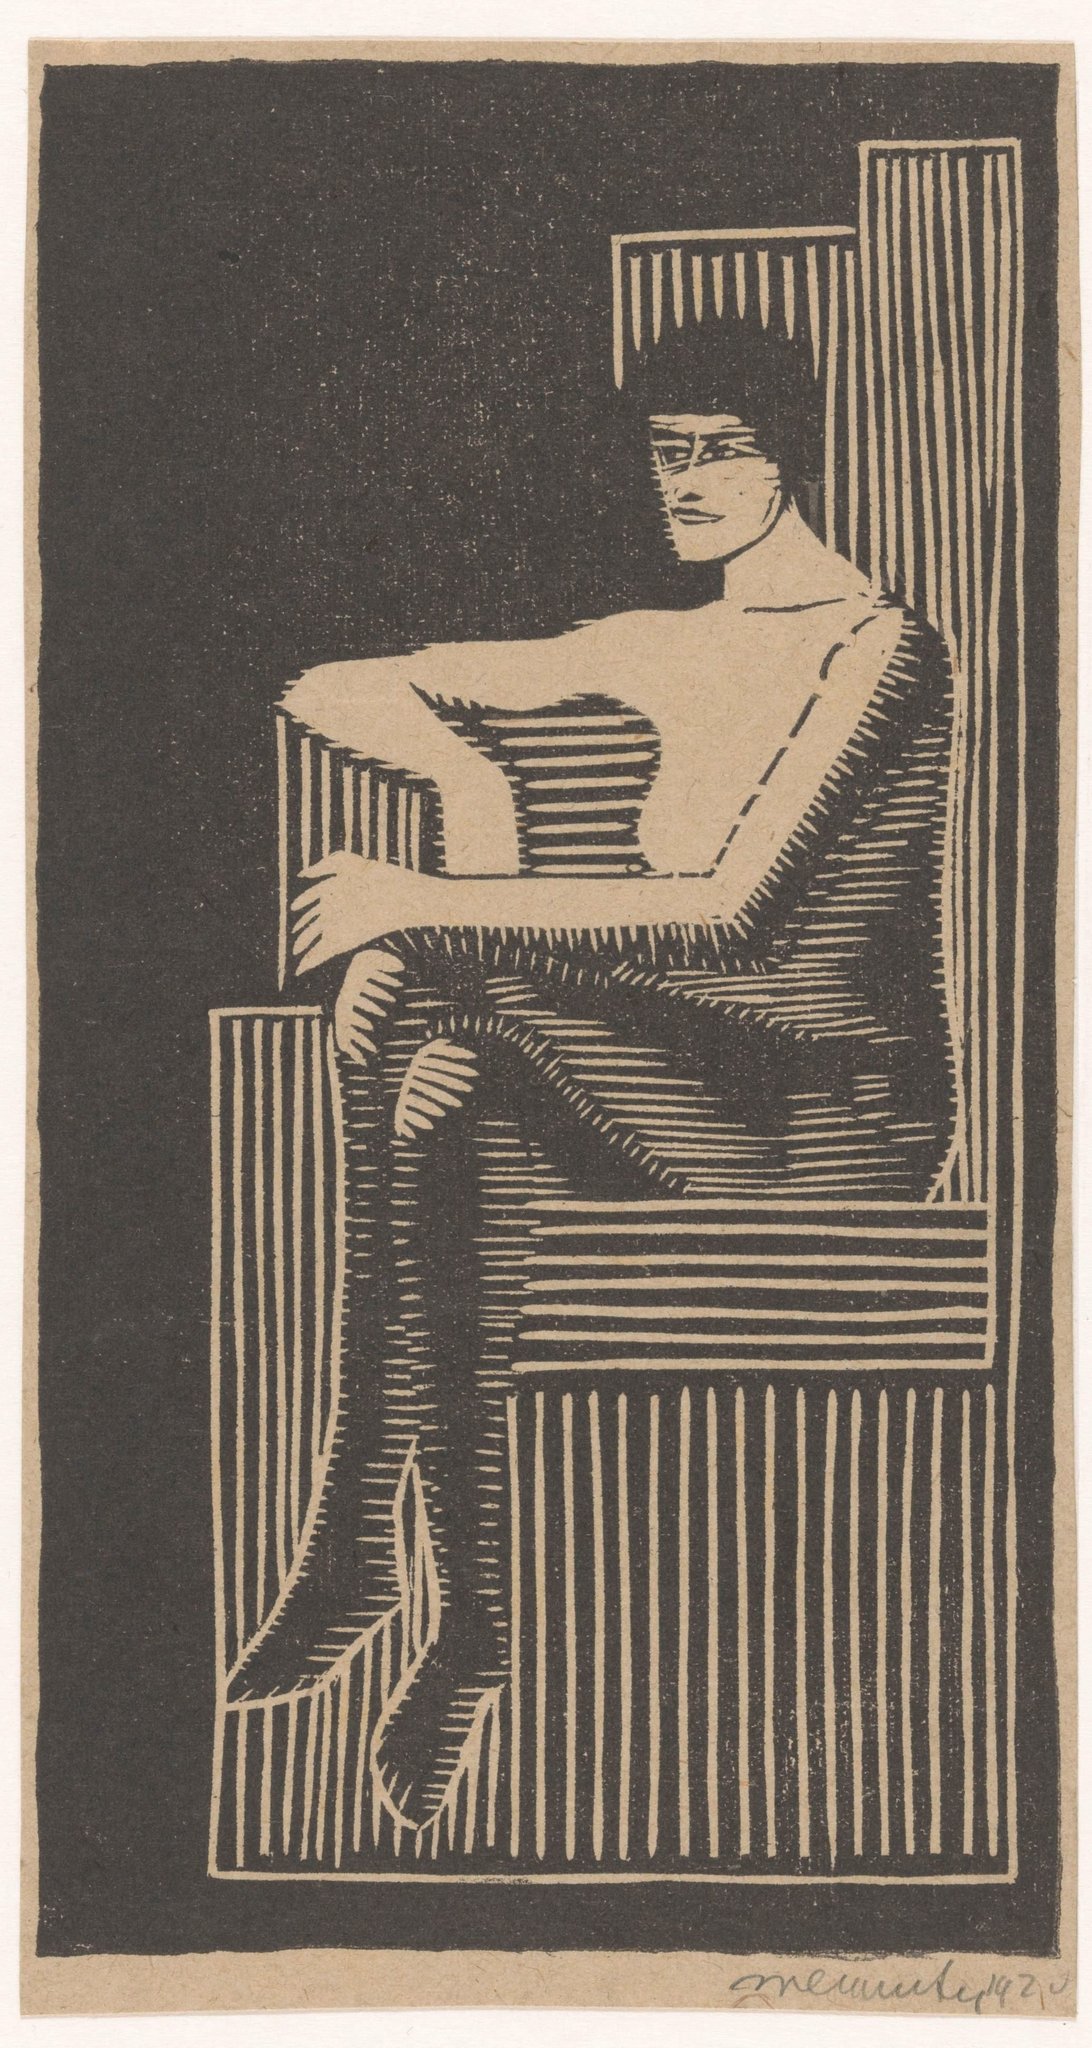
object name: print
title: Zittend naakt in geometrische zetel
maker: samuel jessurun de mesquita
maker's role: draughtsman, print maker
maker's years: 1868-1944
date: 1920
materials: paper, ink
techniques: woodcut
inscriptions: signature and date: ‘Mesquita 1920’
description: Deze afbeelding is gestoken uit langshout, waardoor de nerven van het blok herkenbaar zijn in de afdruk. De voorstelling van een zittende naakte vrouw is bijna volledig opgebouwd uit horizontale en verticale lijnen. Deze opbouw verraadt de achtergrond van Jessurun de Mesquita als docent ‘rechtlijnig tekenen’ en ‘het geometrisch ornament’ rond de vorige eeuwwisseling. Opvallend is het dramatische contrast tussen licht en donker, een element dat onlosmakelijk is verbonden met het werk van Escher.